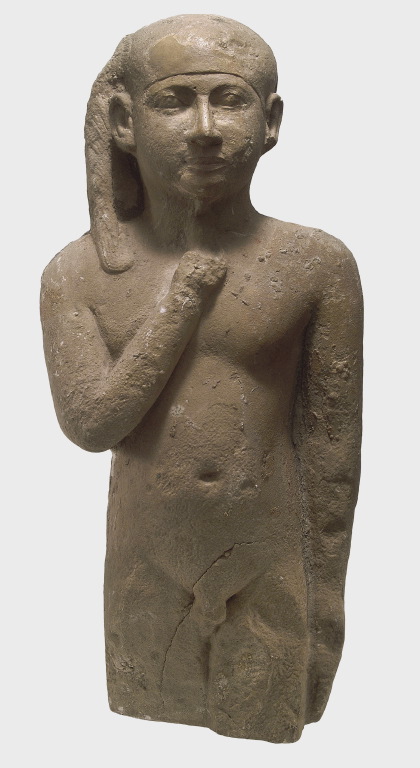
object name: statue, young boy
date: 2465-2323 BCE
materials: limestone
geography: egypt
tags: boys,male nudes